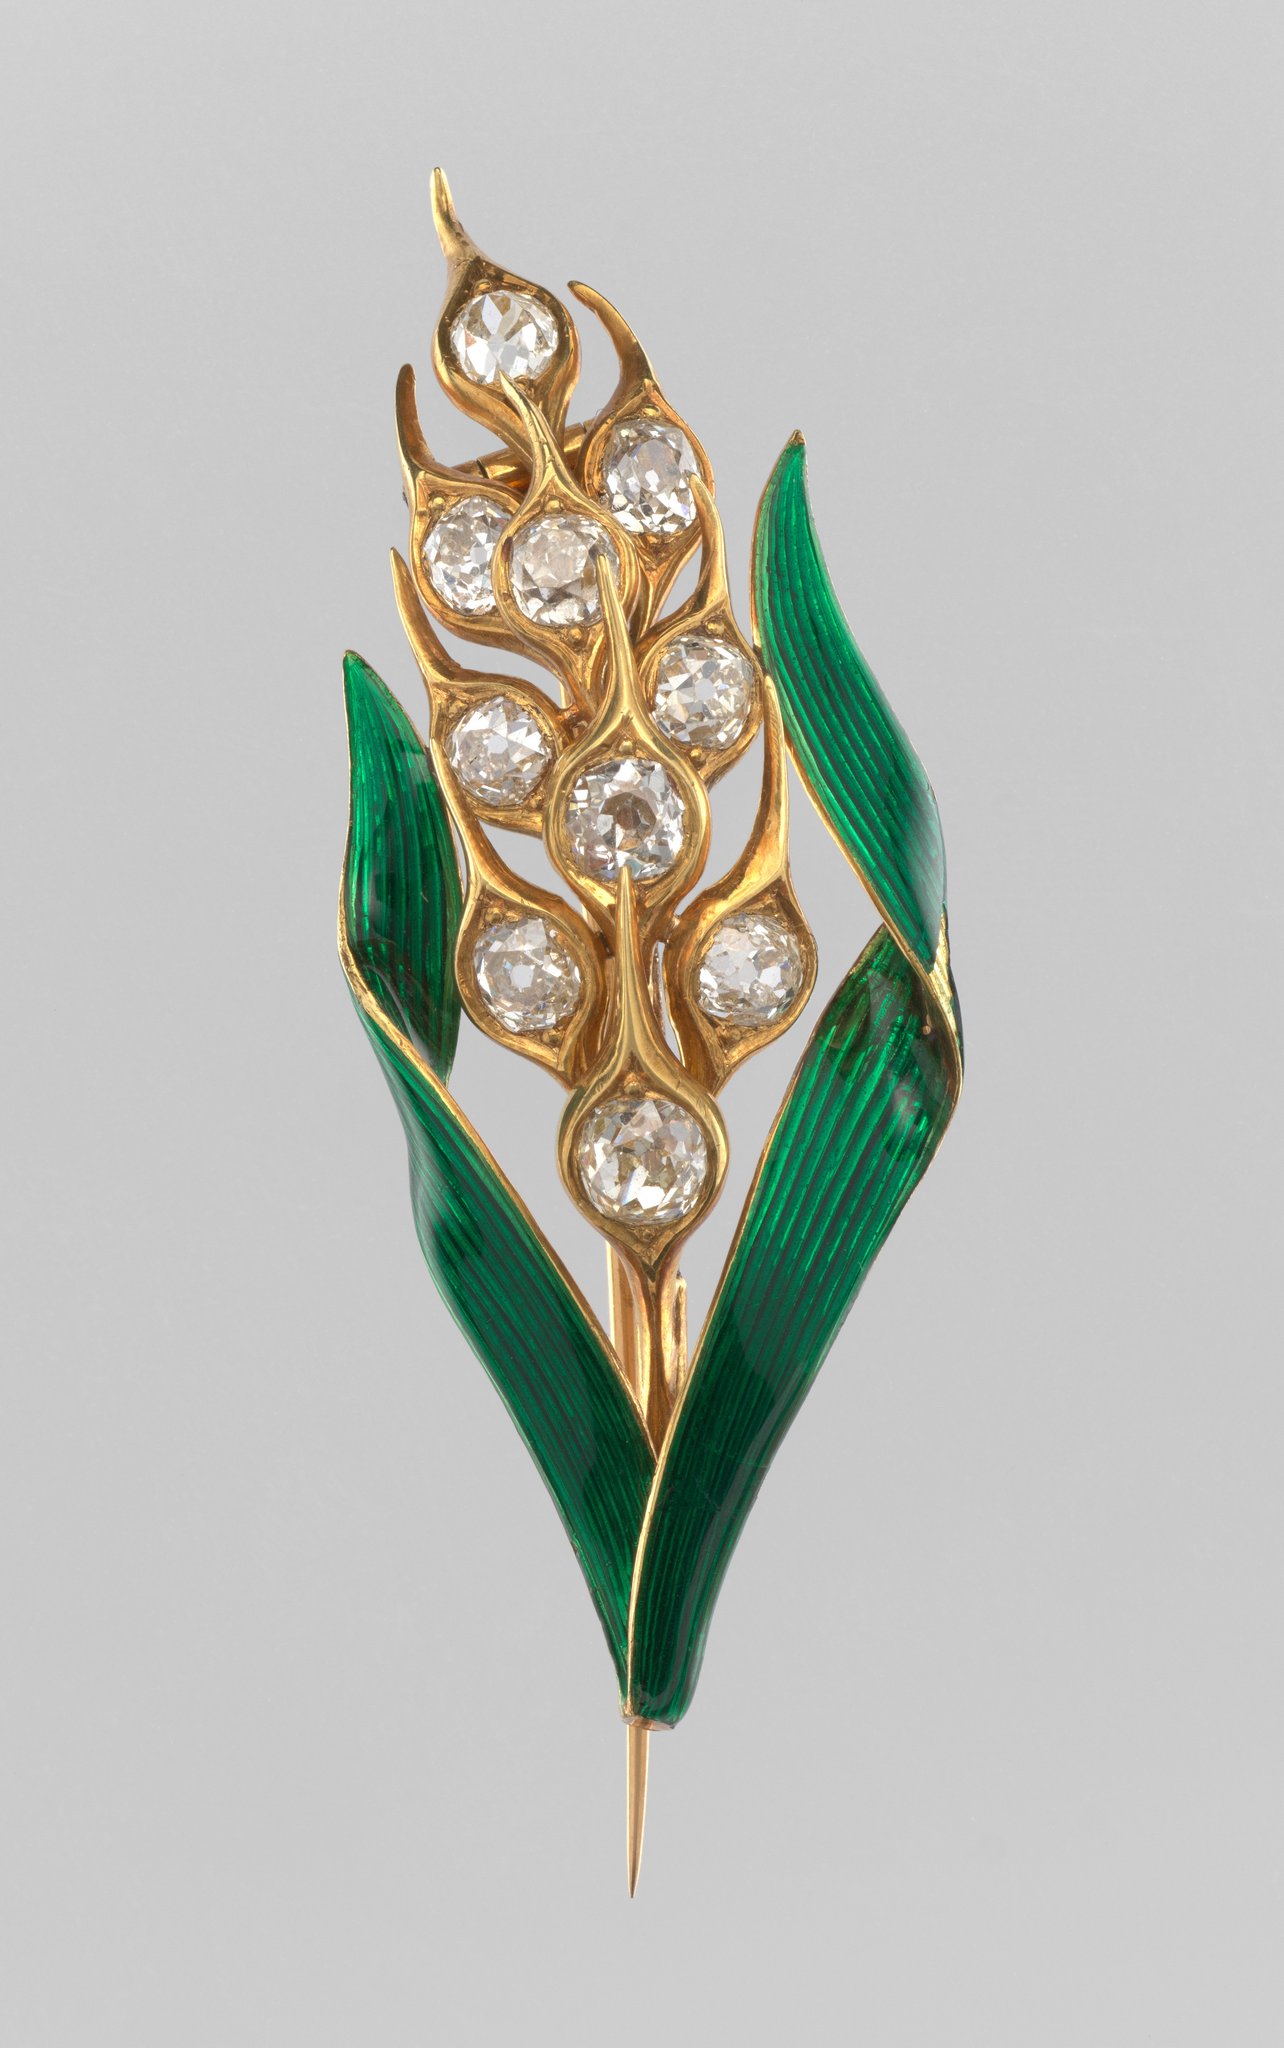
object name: brooch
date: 1801-1900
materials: diamond, gold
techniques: enamel